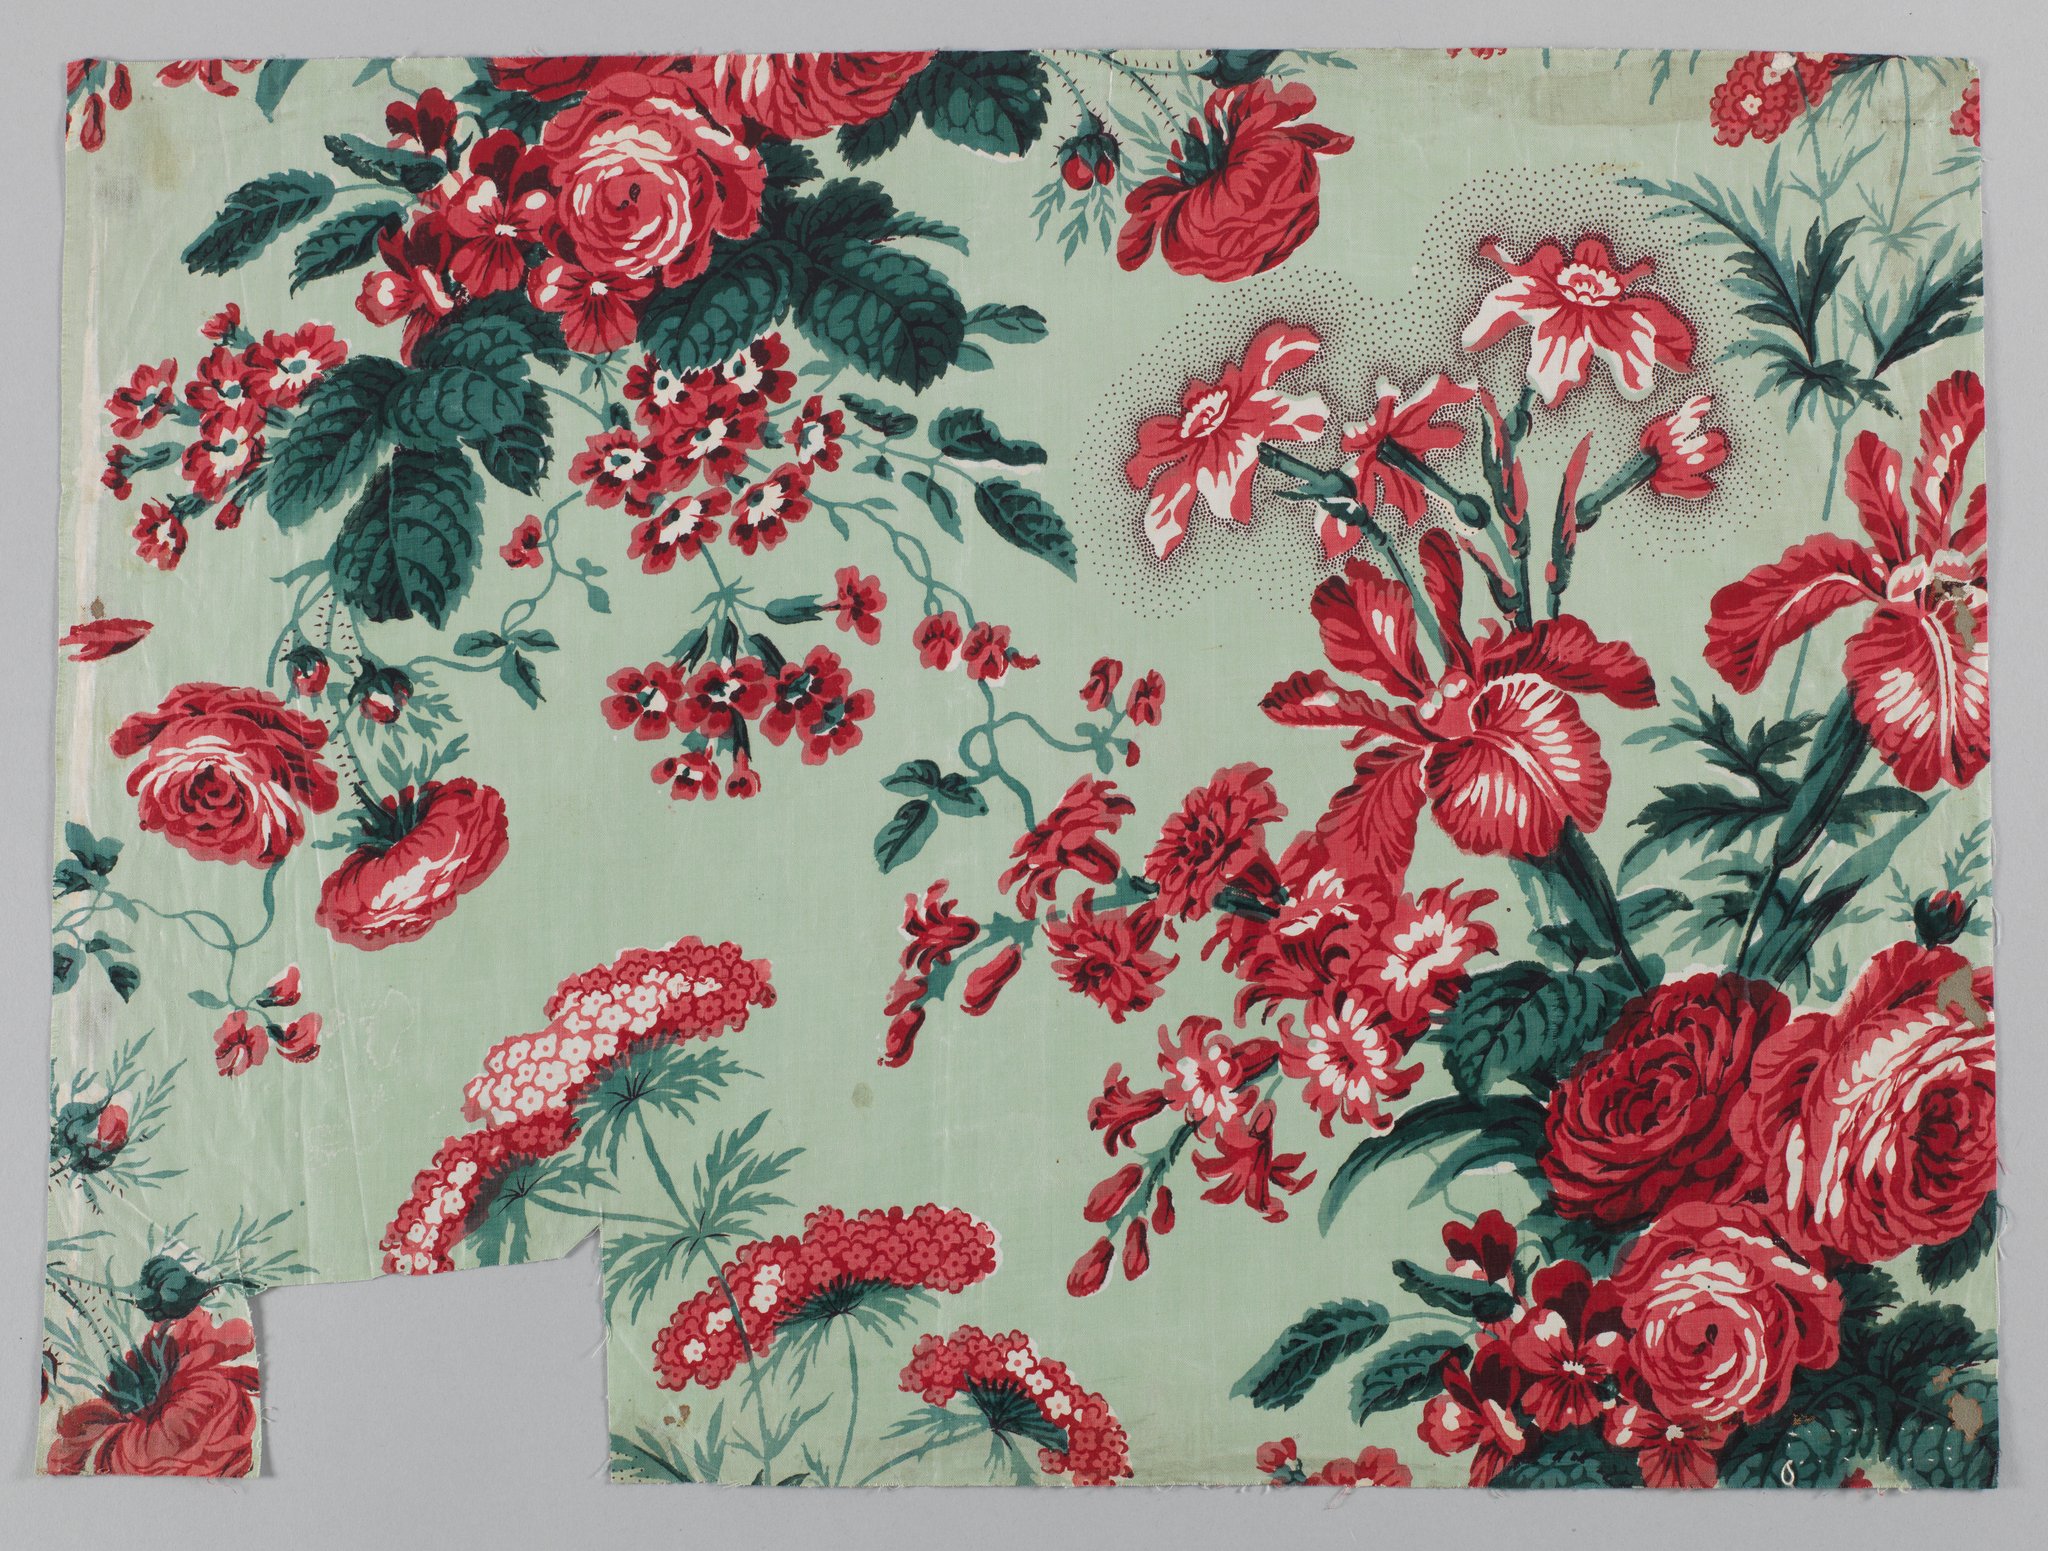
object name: piece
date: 1801-1900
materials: cotton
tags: flowers